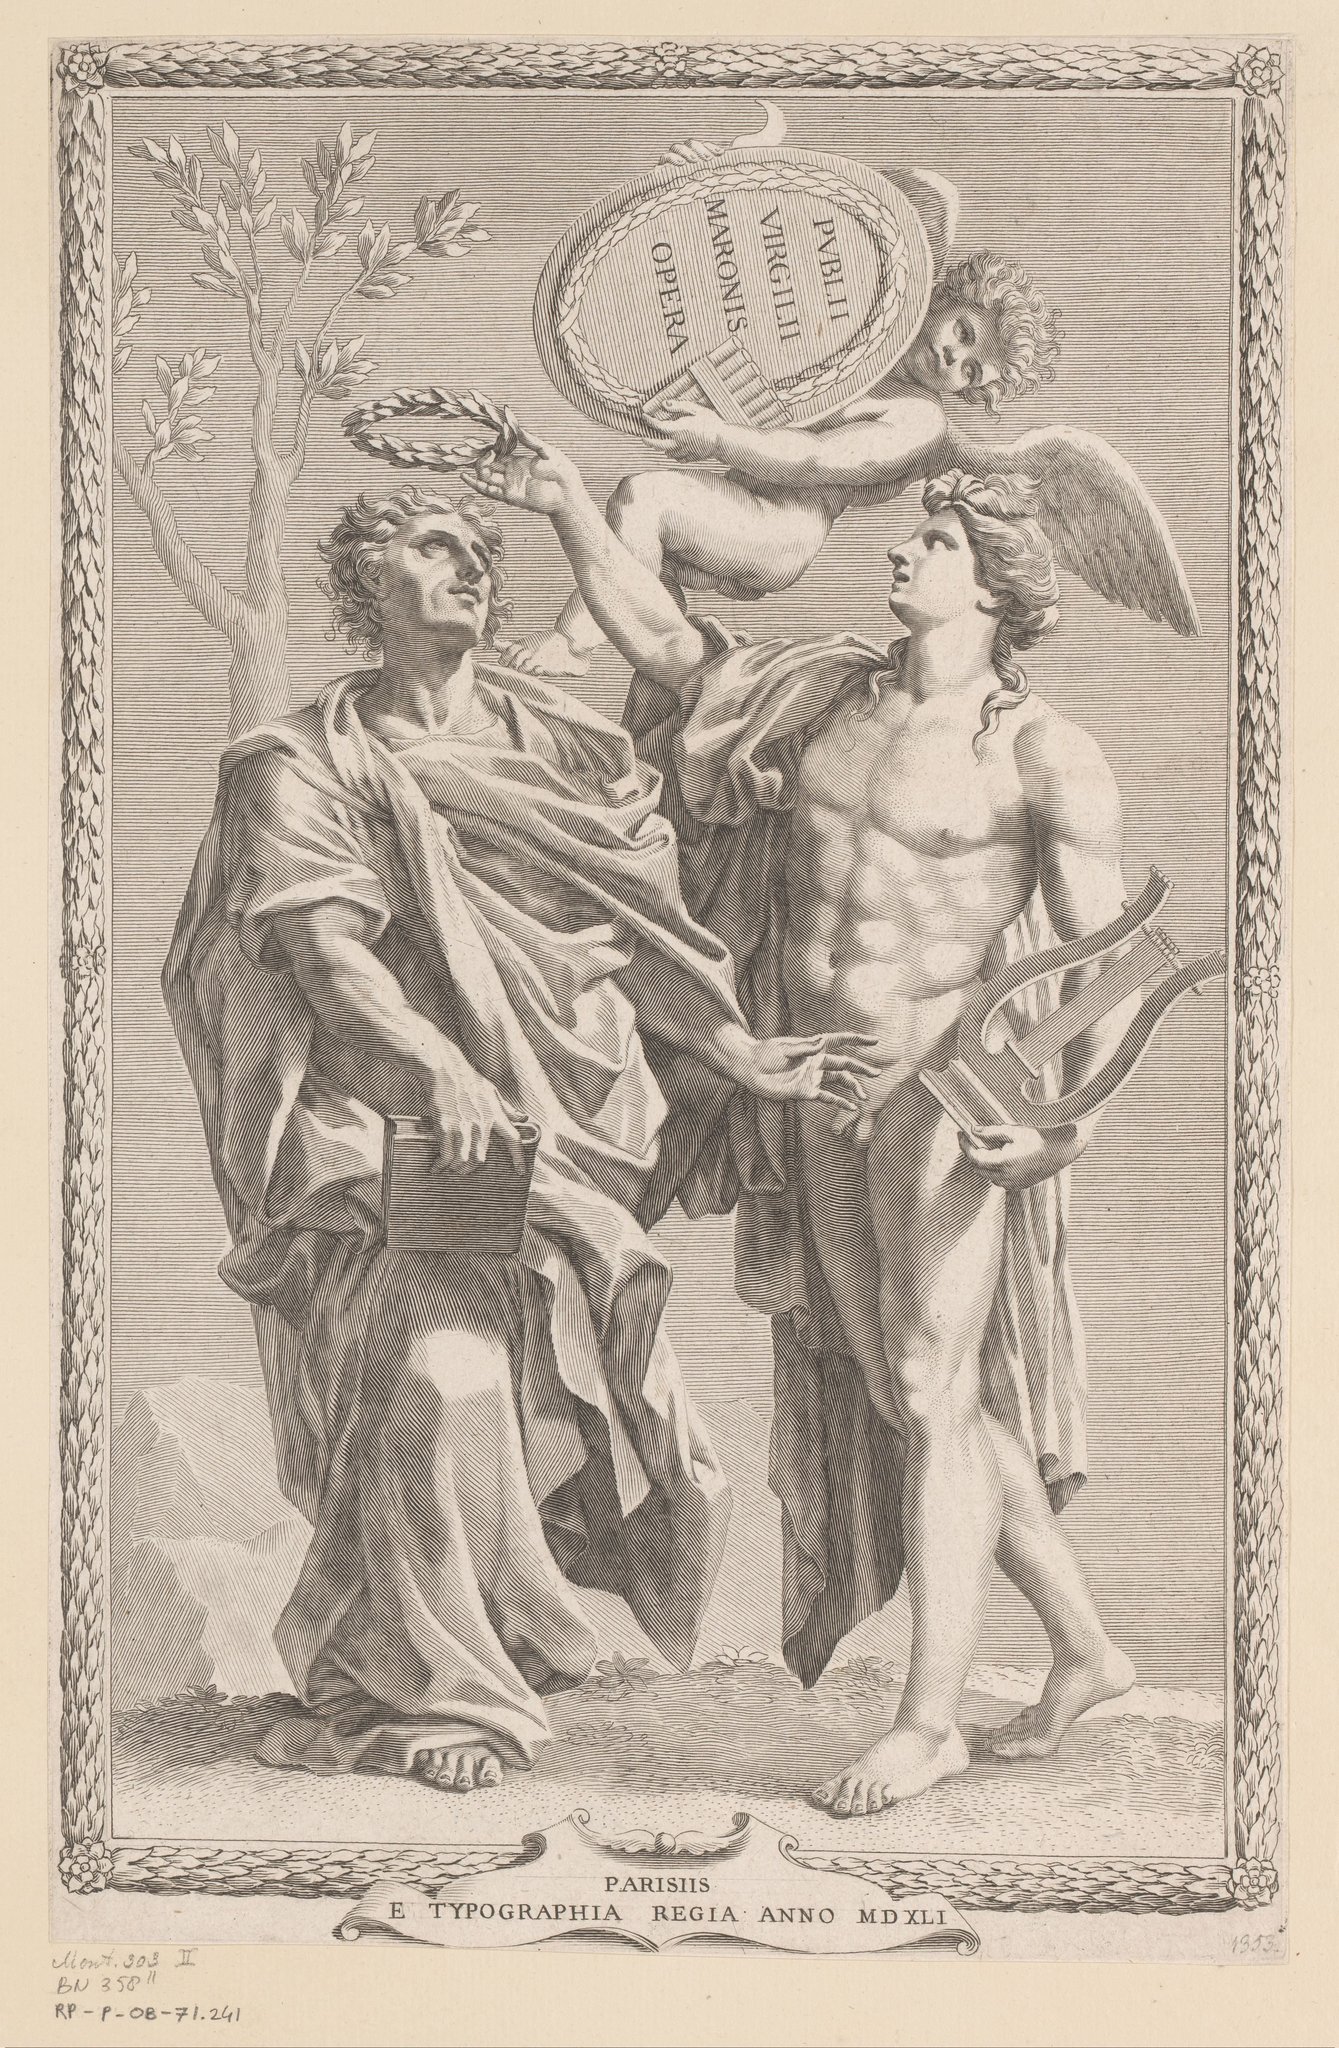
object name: titelblad, titelpagina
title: Titelpagina voor: Publius Vergilius Maro, Publii Virgilii Maronis Opera, 1641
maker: claude mellan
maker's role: draughtsman, print maker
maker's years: 1598-1688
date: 1641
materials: paper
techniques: engraving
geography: paris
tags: publius vergilius maro, (story of) apollo (phoebus), historical persons, crowning with laurel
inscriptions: collector's mark: Lugt 240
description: Titelpagina voor: Vergilius Maro, Publius. Publii Virgilii Maronis Opera. Parijs: Imprimerie Royale, 1641. De voorbereidende tekening door Poussin bevindt zich Windsor, inv.nr. 11948.